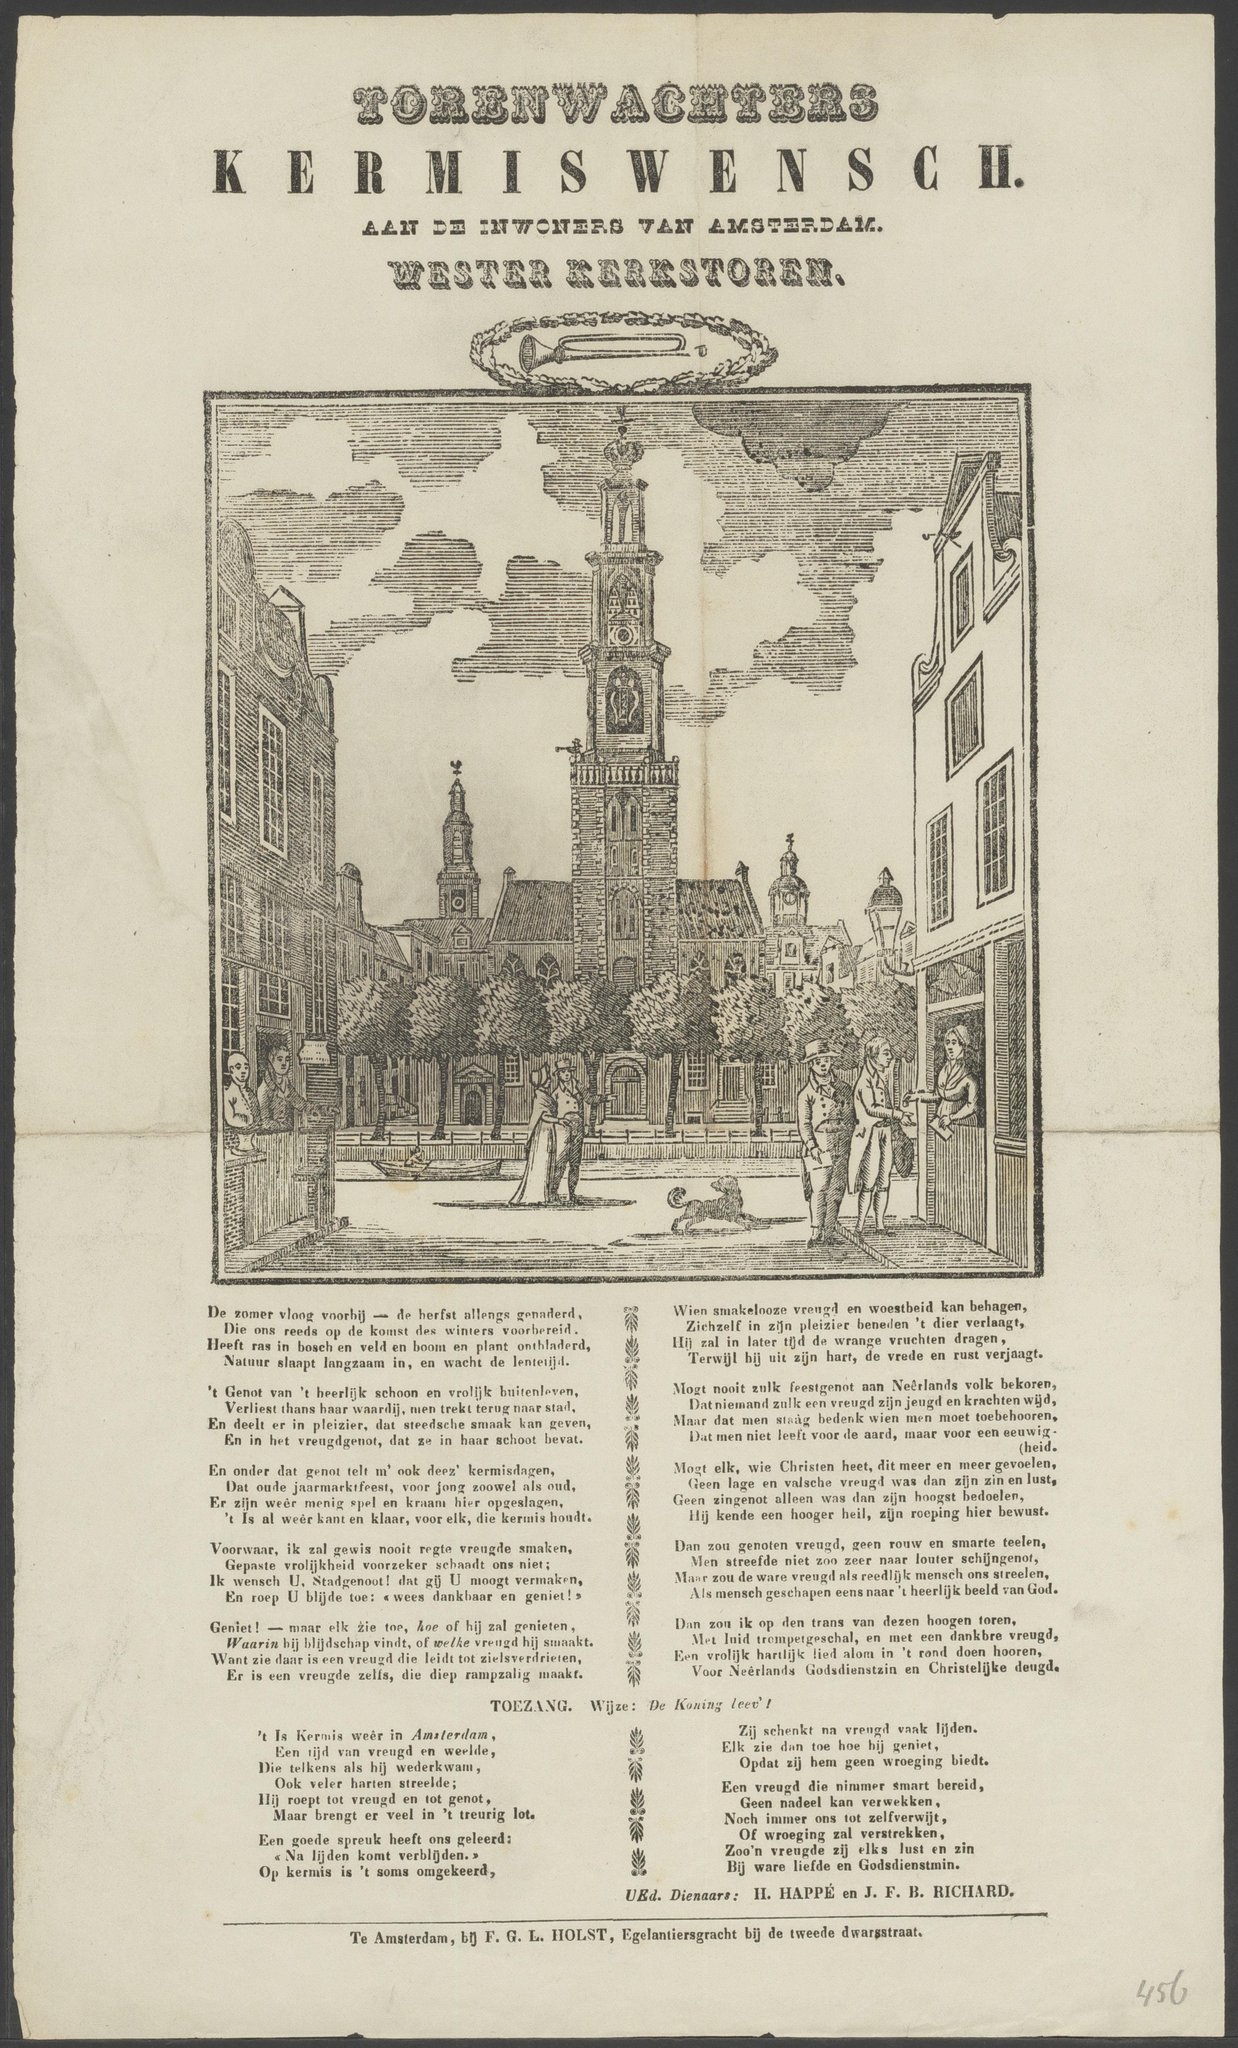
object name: print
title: Torenwachters kermiswensch. Aan de inwoners van Amsterdam. Wester kerkstoren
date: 1841-1864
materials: paper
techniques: letterpress printing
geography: amsterdam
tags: parts of church exterior and annexes: tower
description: Nieuwjaarswens van de torenwachters van de Westerkerkstoren te Amsterdam. Bovenaan een gezicht op een kerktoren. Daaronder centraal een gedicht in twee kolommen. Onderaan een toezang in twee kolommen. Aangeboden door de torenwachters: H. Happé en J.F.B. Richard. Onderwerpsrubrieken binnen de Atlas Zeden en Gewoonten: Zeden en gewoonten in engeren zin, Volksleven, Volksbladen, Nieuwjaars- en Kerstwenschen, Amsterdam.